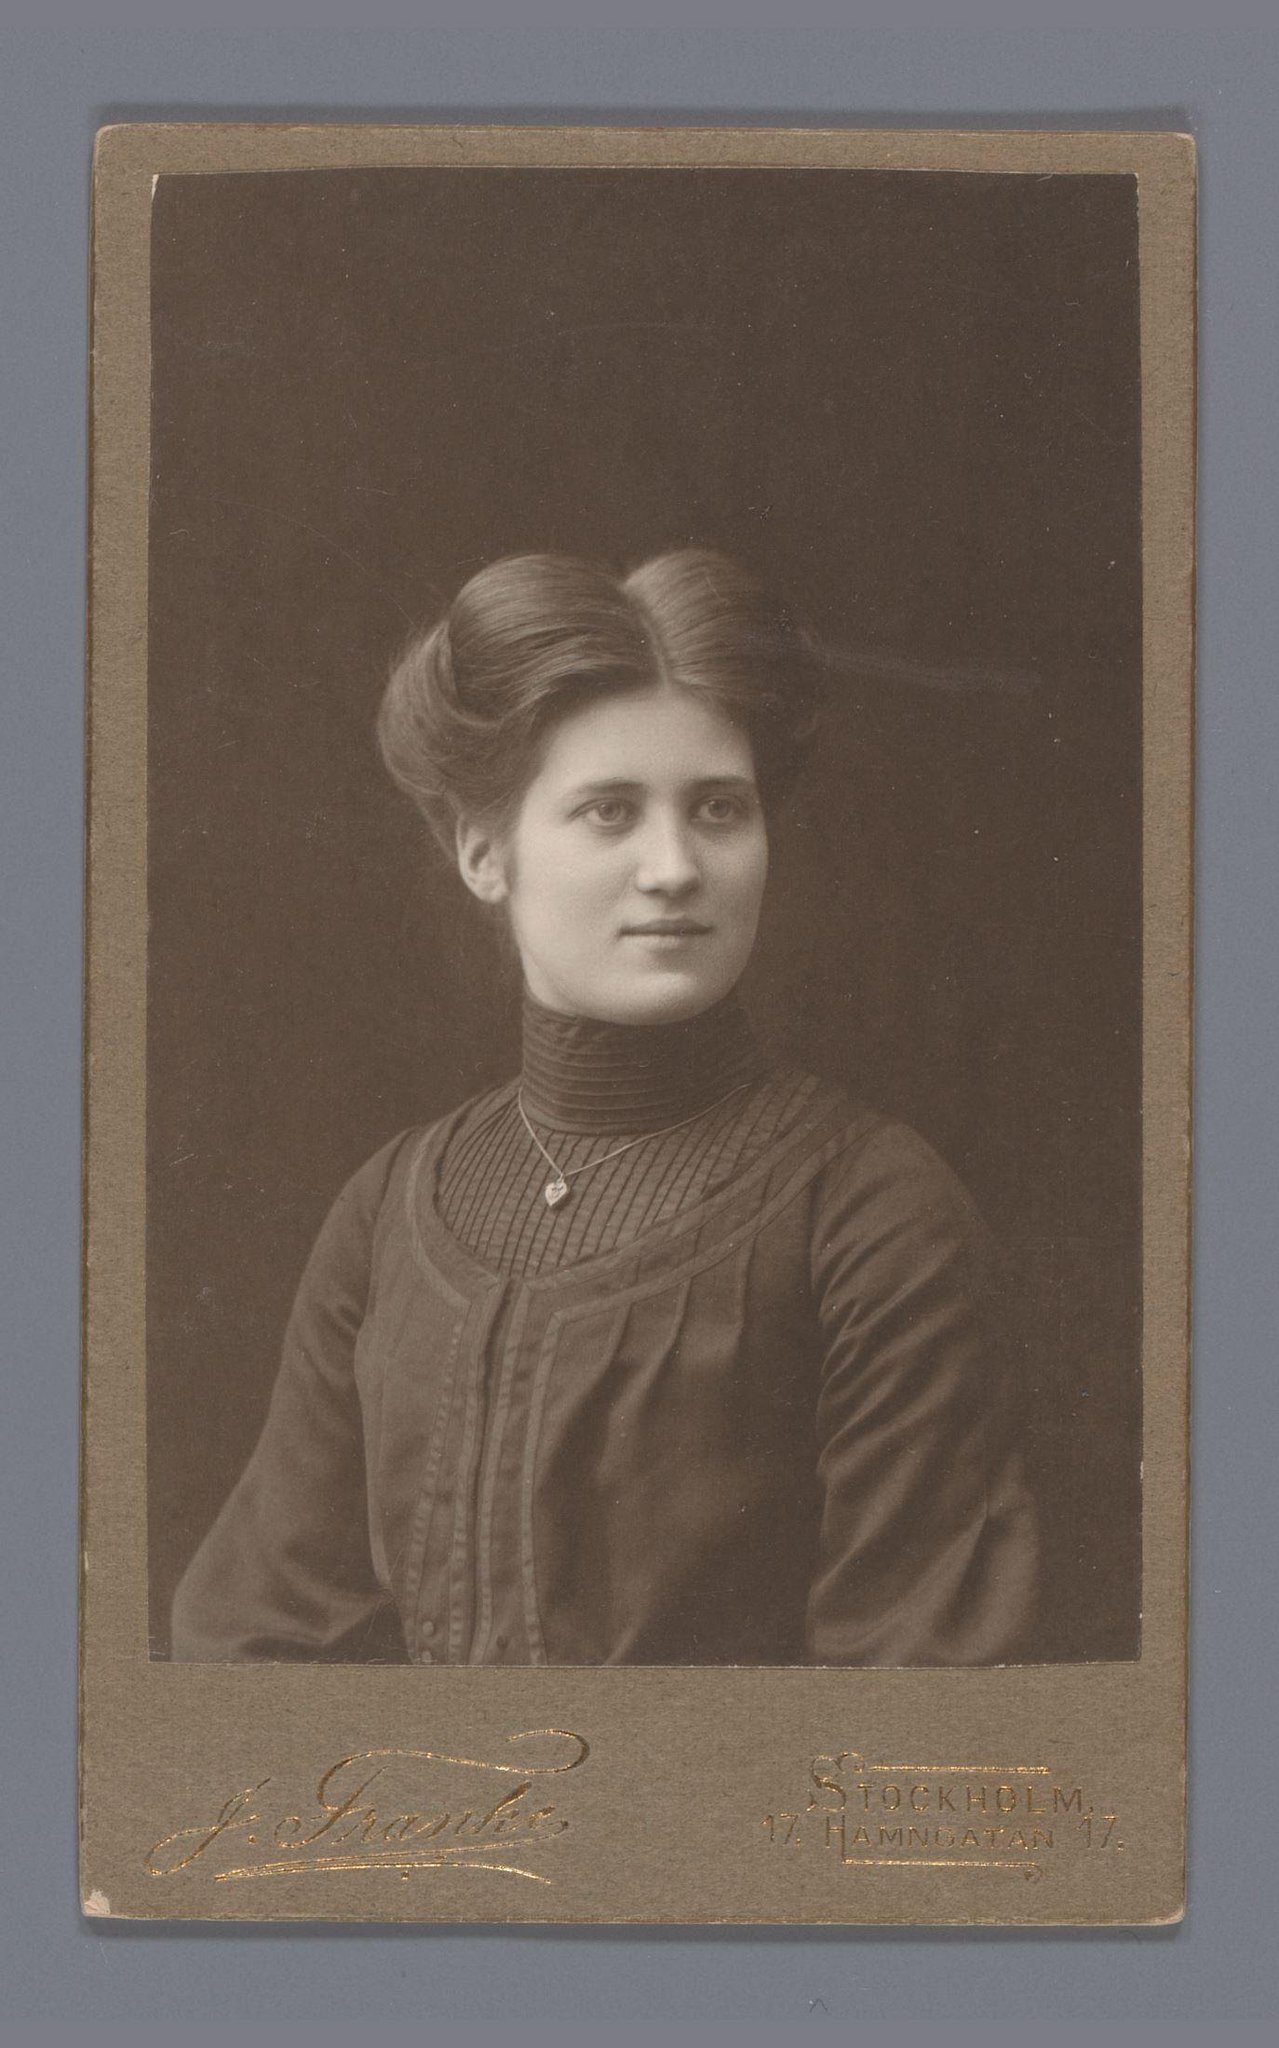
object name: carte de visite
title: Portret van een onbekende vrouw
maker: j. franke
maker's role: fotograaf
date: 1895-1920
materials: cardboard, photographic support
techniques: matte daylight collodion silver print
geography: stockholm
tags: adolescent, young woman, maiden, historical persons - bb - woman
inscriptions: inscription: ‘J. Franke/ Allm. Tel. 8836./ Österm. 508./ STOCKHOLM/ HAMNGATAN 17./ MALMSKILLNADSG. 3 B./ PLÅTEN FÖRVARAS’, address: ‘STOCKHOLM./ 17. HAMNGATAN 17.’